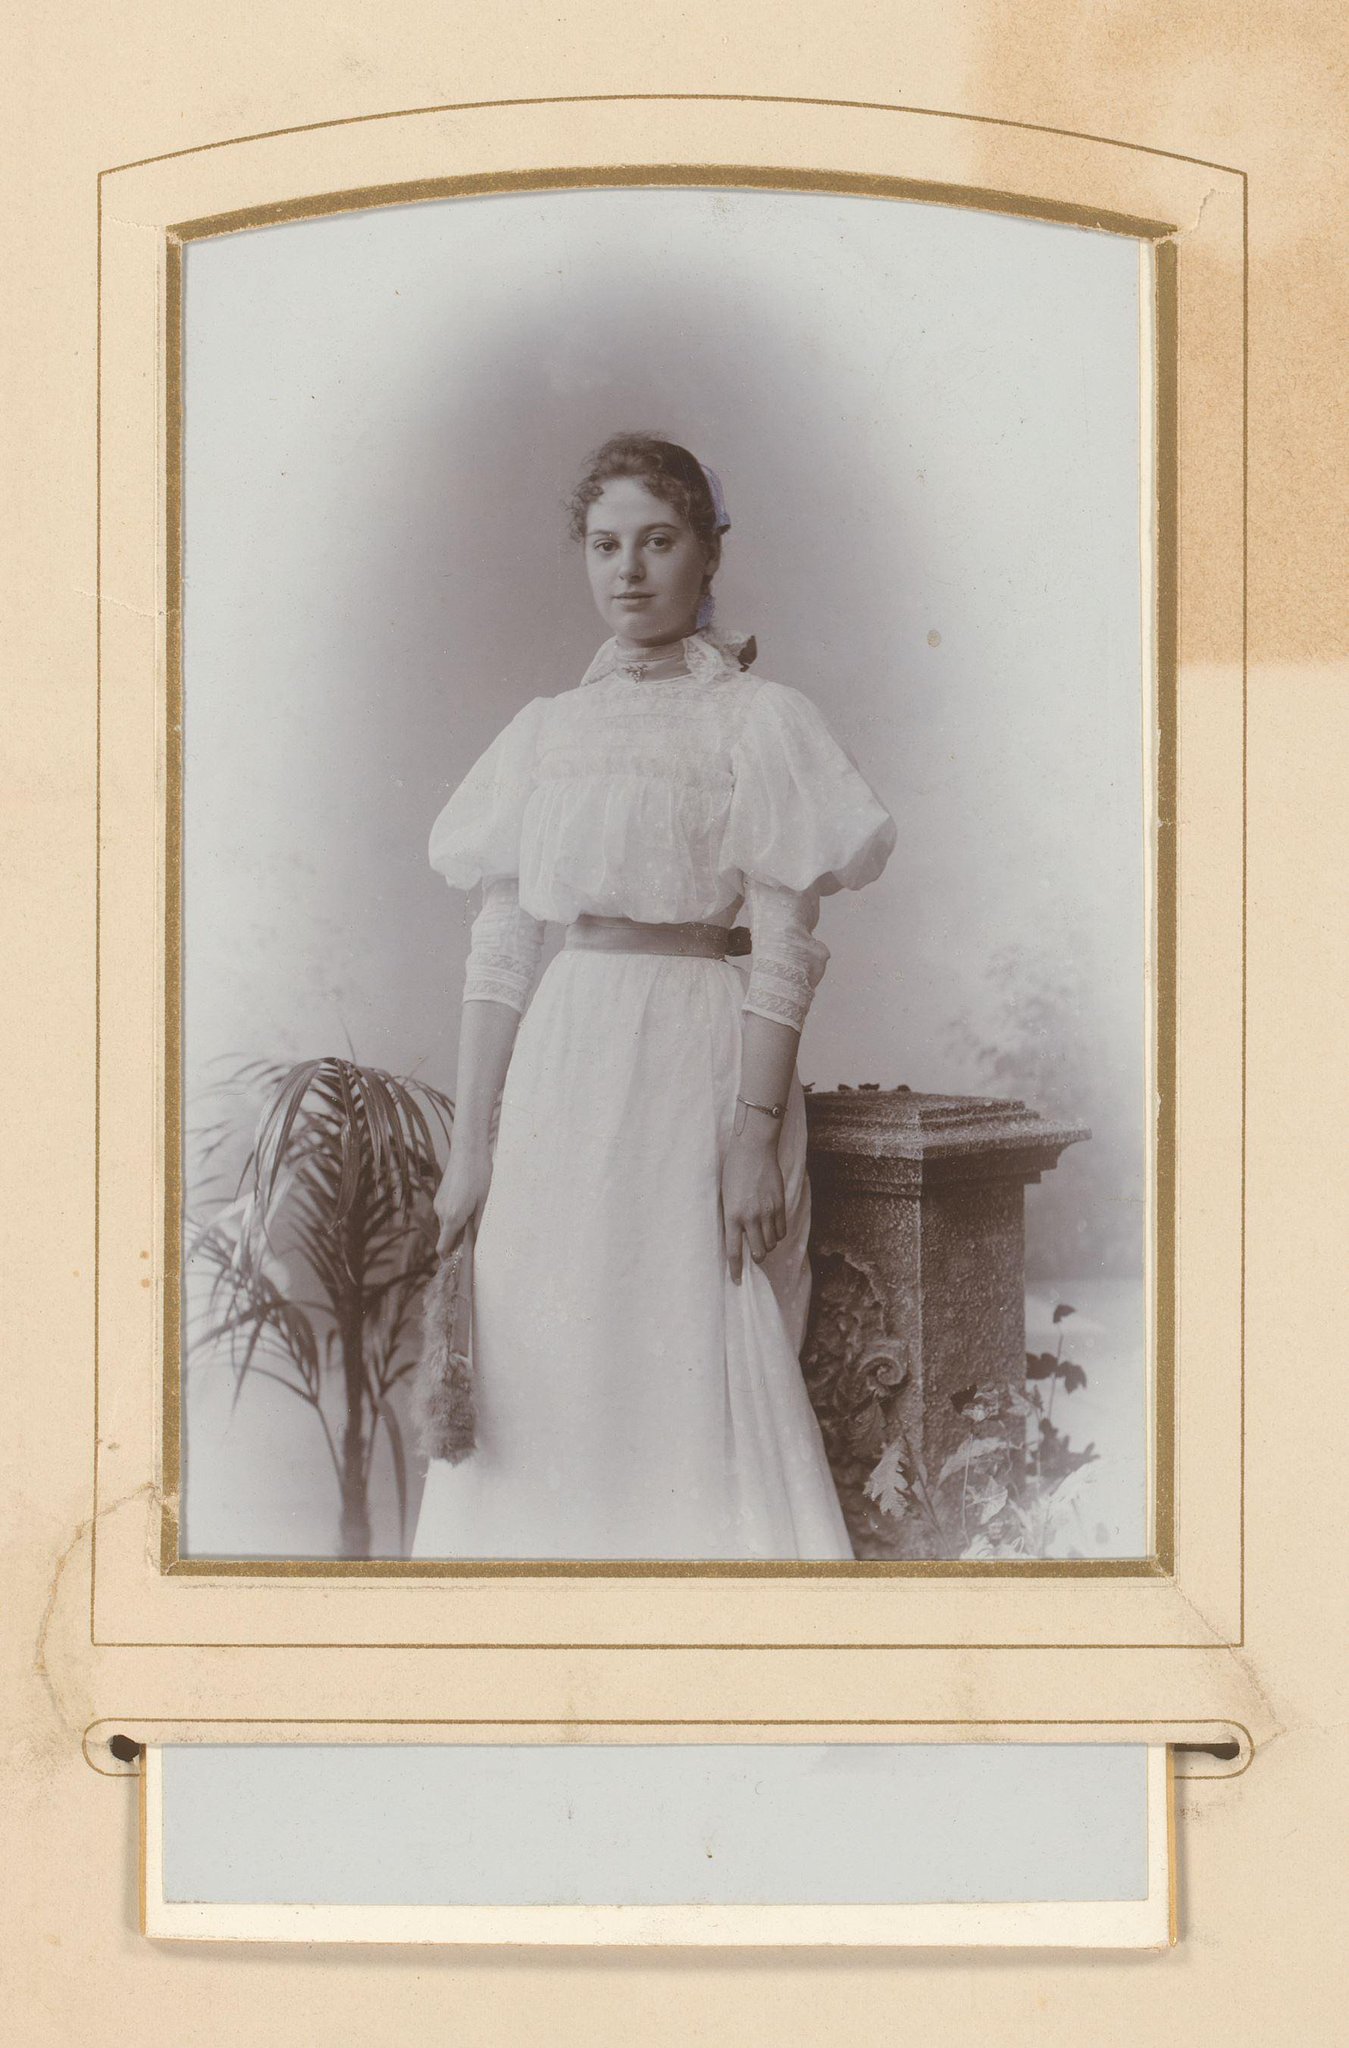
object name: album leaf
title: Portret van een vrouw met waaier in de hand, bij een sokkel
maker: Anonymous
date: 1880-1920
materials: cardboard, photographic support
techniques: collodion silver print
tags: historical persons - bb - woman, fan, pedestal of a piece of sculpture (perhaps in the form of a herm)